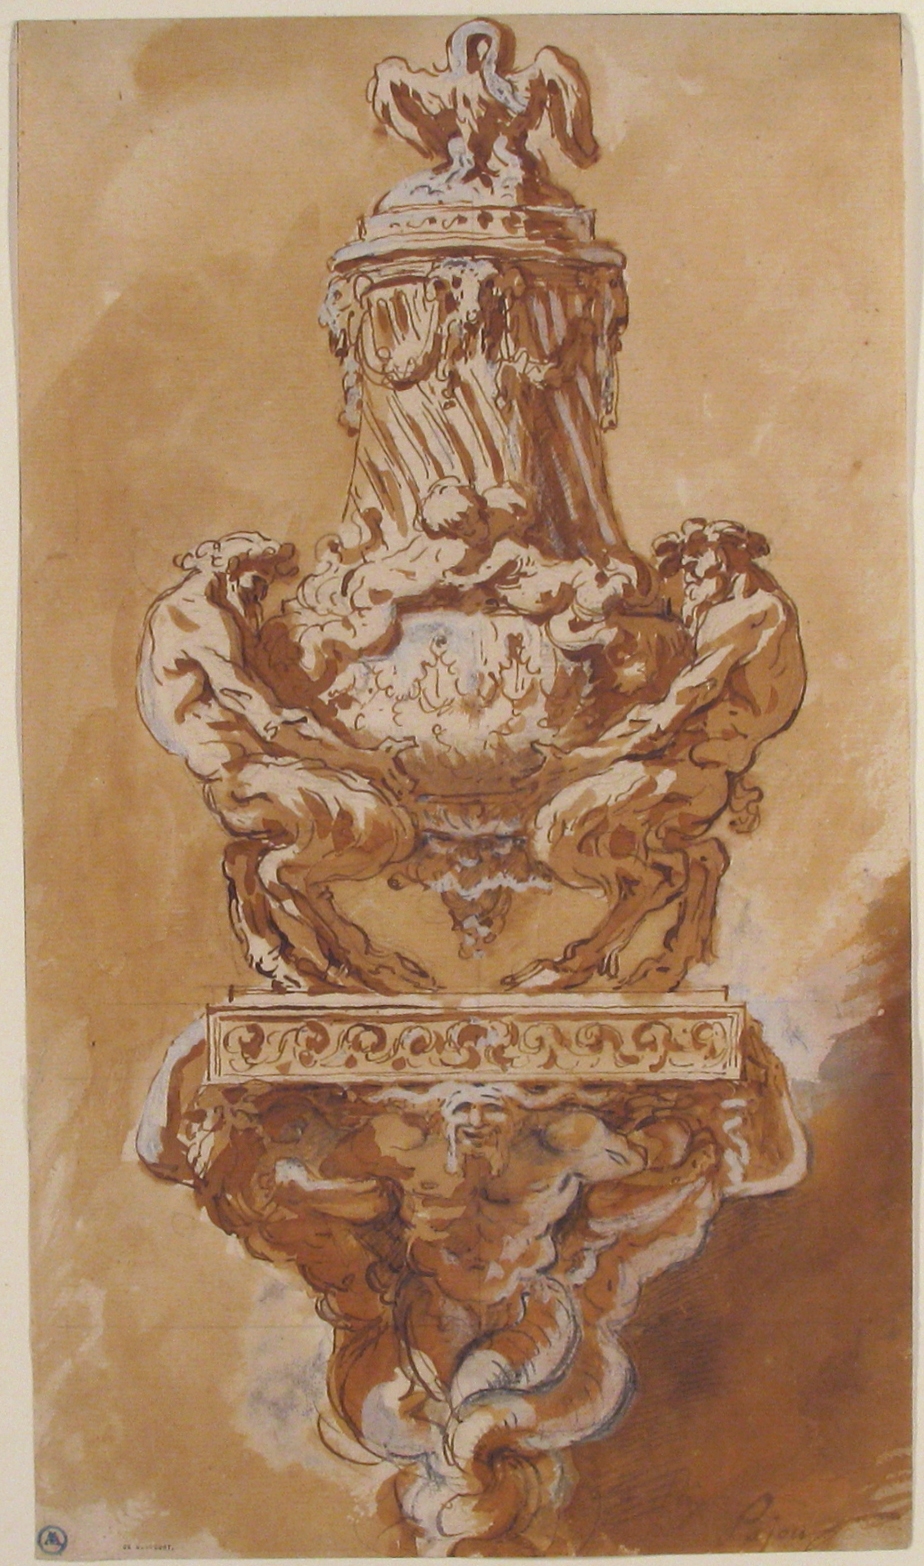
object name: drawing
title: Design for a Vase and Supporting Console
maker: augustin pajou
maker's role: artist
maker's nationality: french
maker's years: 1730-1809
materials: chalk, gouache, ink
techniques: brush, heightening, pen, wash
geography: france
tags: human figures